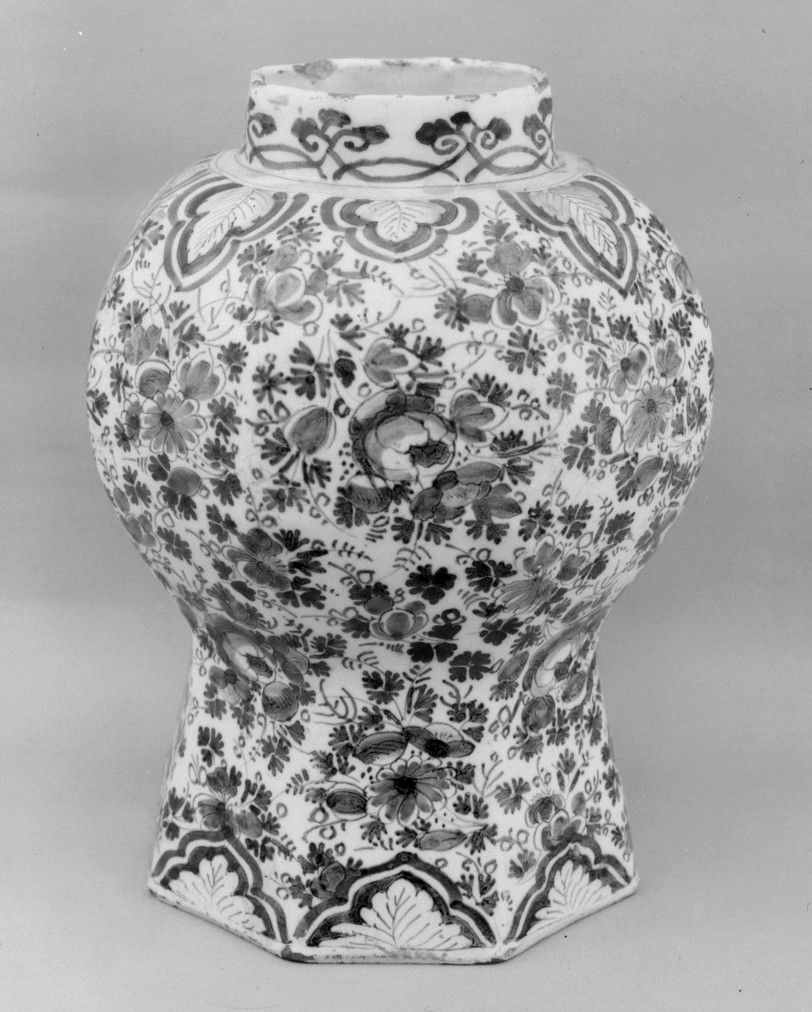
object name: vase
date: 1667-1733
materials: earthenware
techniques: glazing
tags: flowers